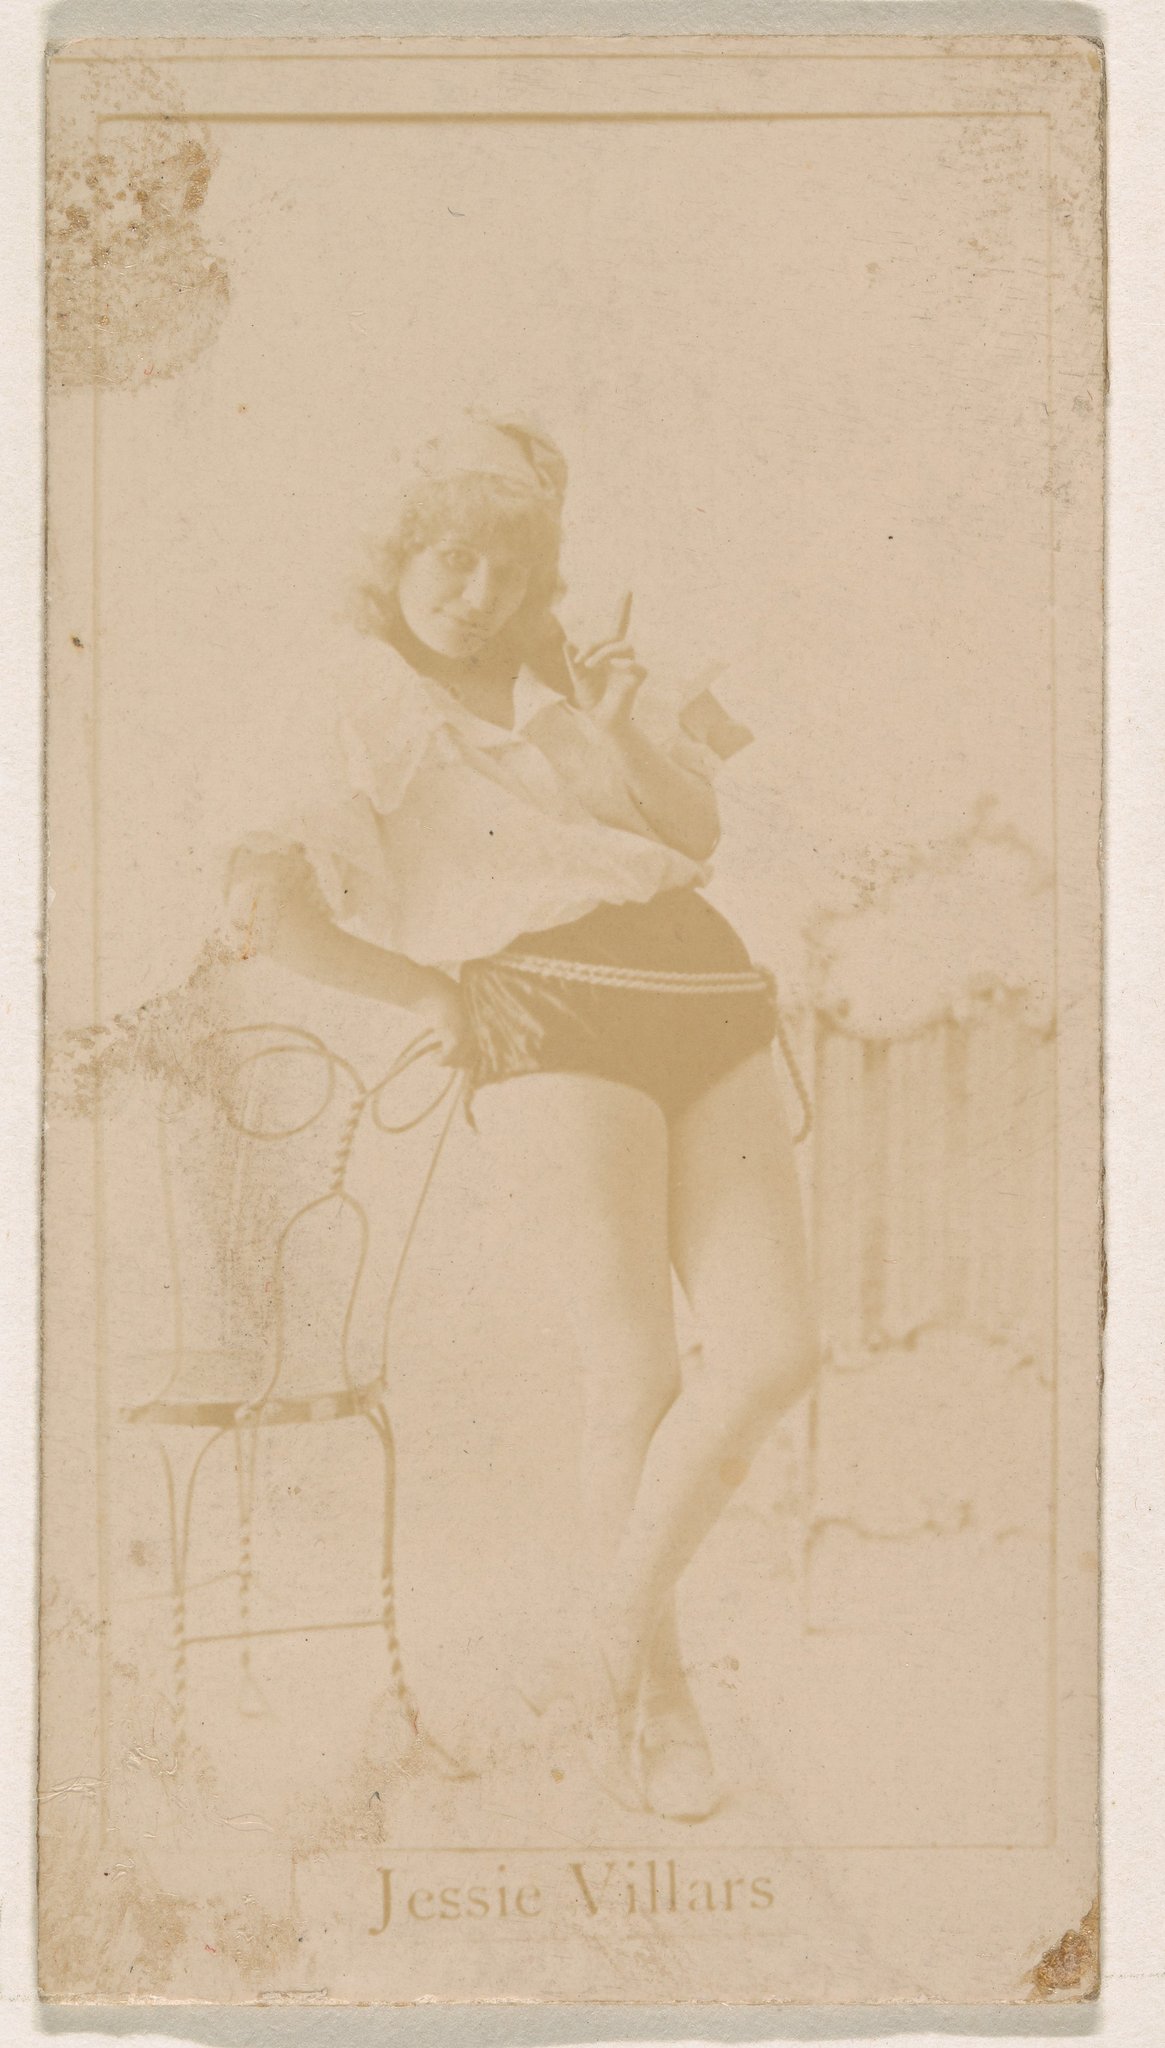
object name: photograph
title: Jessie Villars, from the Actresses series (N245) issued by Kinney Brothers to promote Sweet Caporal Cigarettes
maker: kinney brothers tobacco company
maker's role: publisher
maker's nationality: american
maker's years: 1869-2011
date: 1890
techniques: albumen silver print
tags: portraits,women,actresses